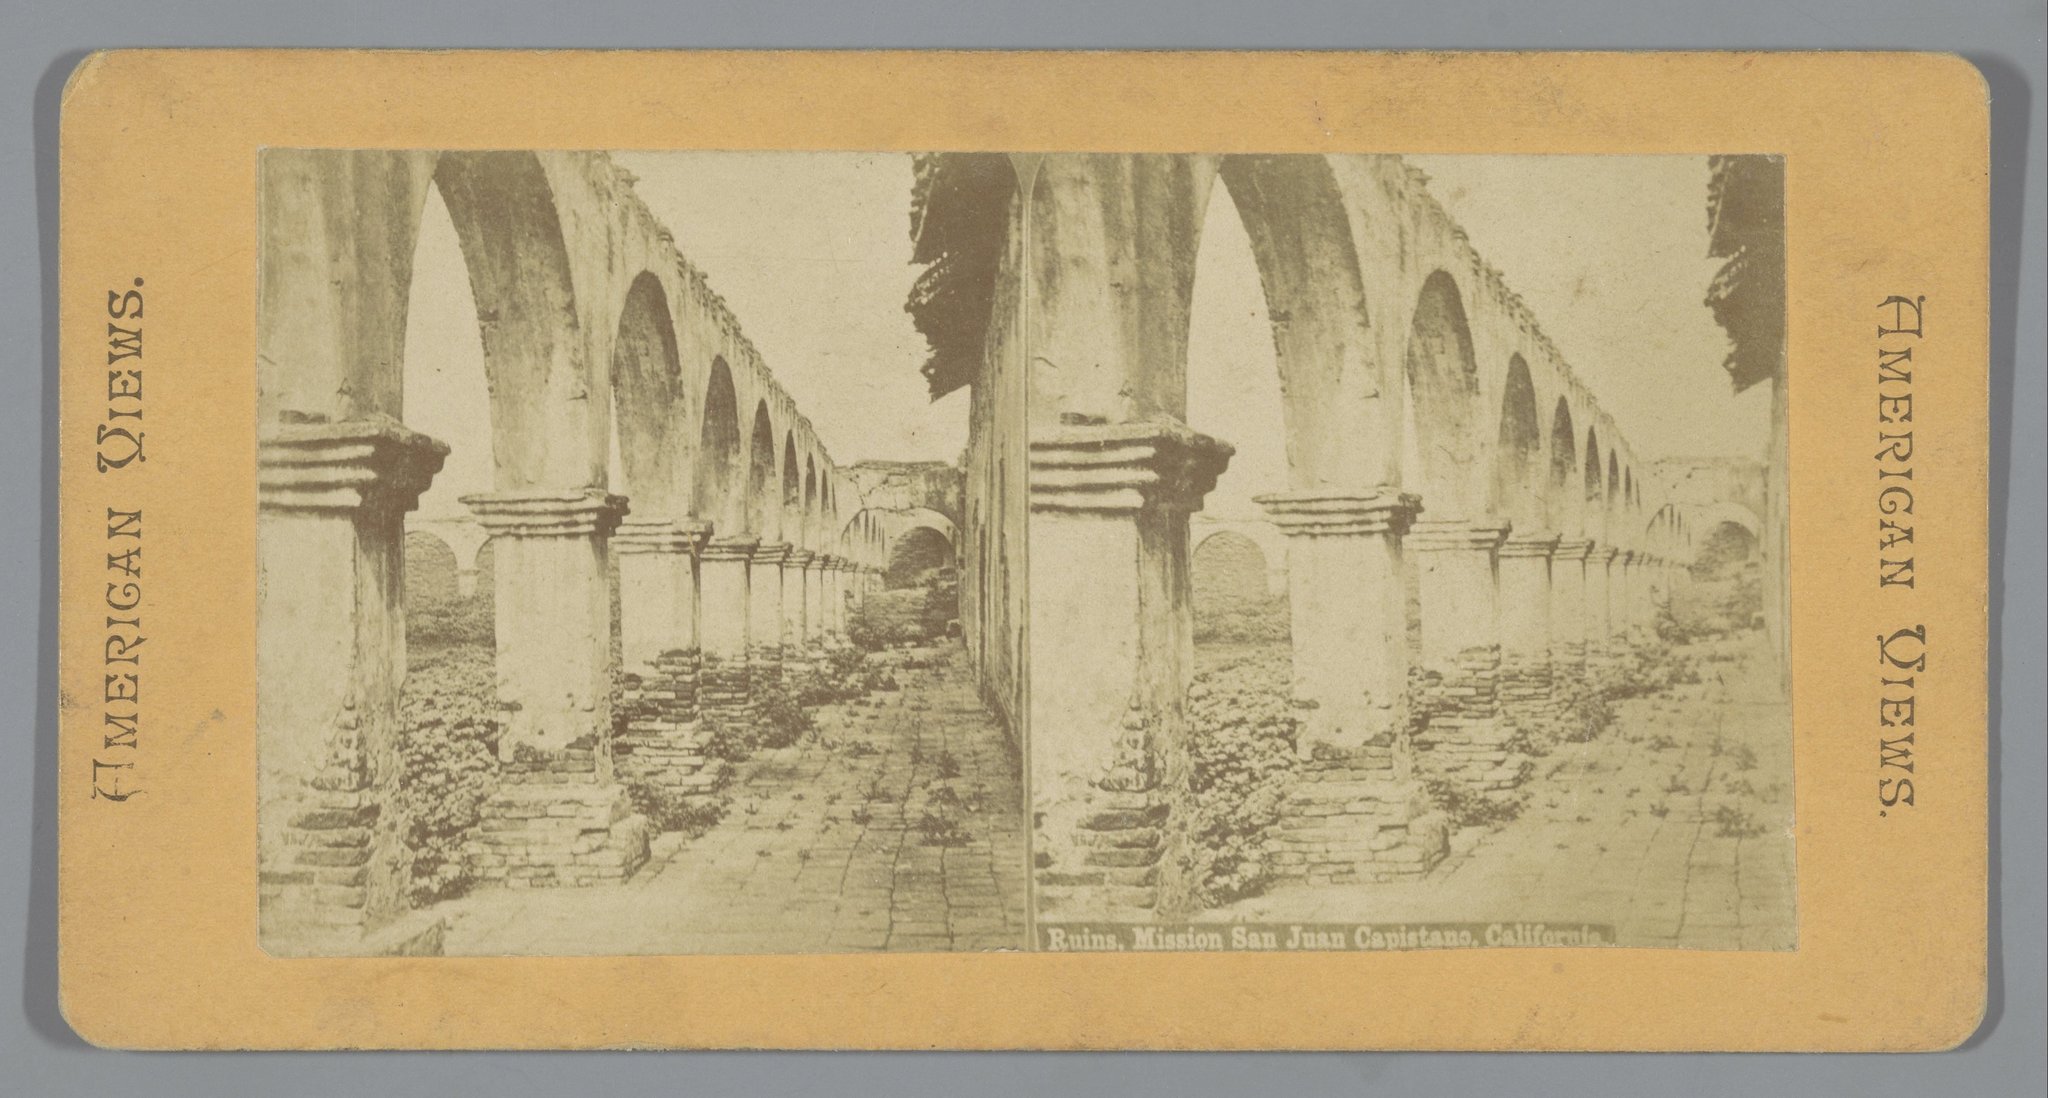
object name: stereograph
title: Ruins, Mission San Juan Capistano, California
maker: Anonymous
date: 1873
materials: cardboard, paper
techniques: albumen print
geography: san juan capistrano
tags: ruin of church, monastery, etc.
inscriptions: inscription: ‘[...] 1873/ 8’